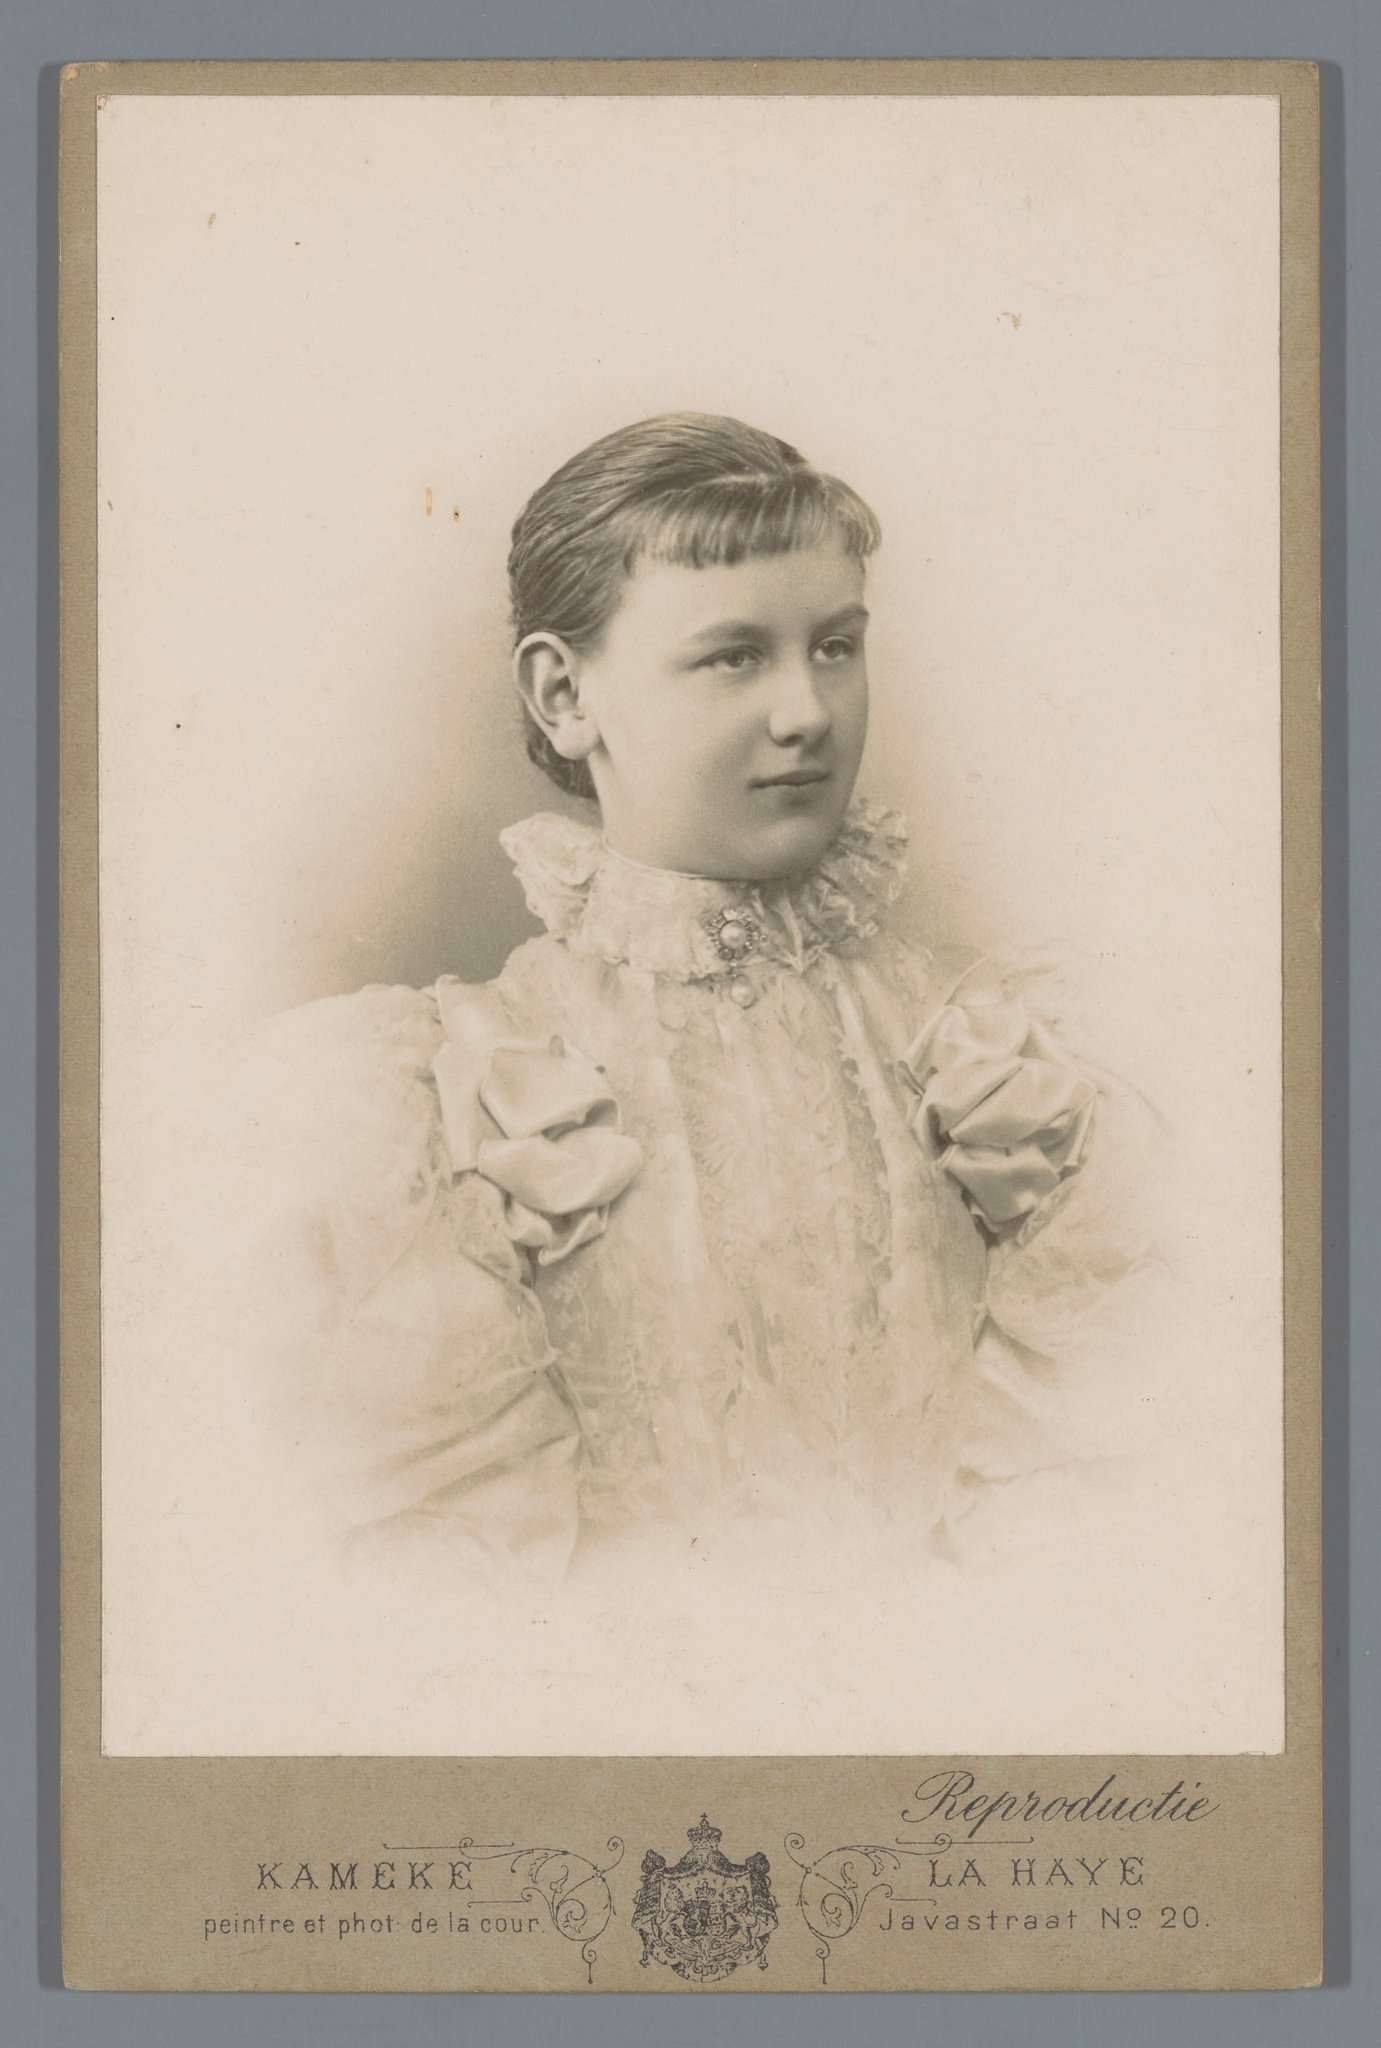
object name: cabinet photograph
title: Portret van prinses Wilhelmina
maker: kameke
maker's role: painter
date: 1896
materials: cardboard, photographic support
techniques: collodion silver print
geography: the hague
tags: the hague, print maker, wilhelmina of the netherlands, crown princess, historical persons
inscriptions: inscription: ‘KAMEKE/ peintre et phot. de la cour./ Reproductie/ LA HAYE/ Javastraat No. 20.’, inscription: ‘1896’